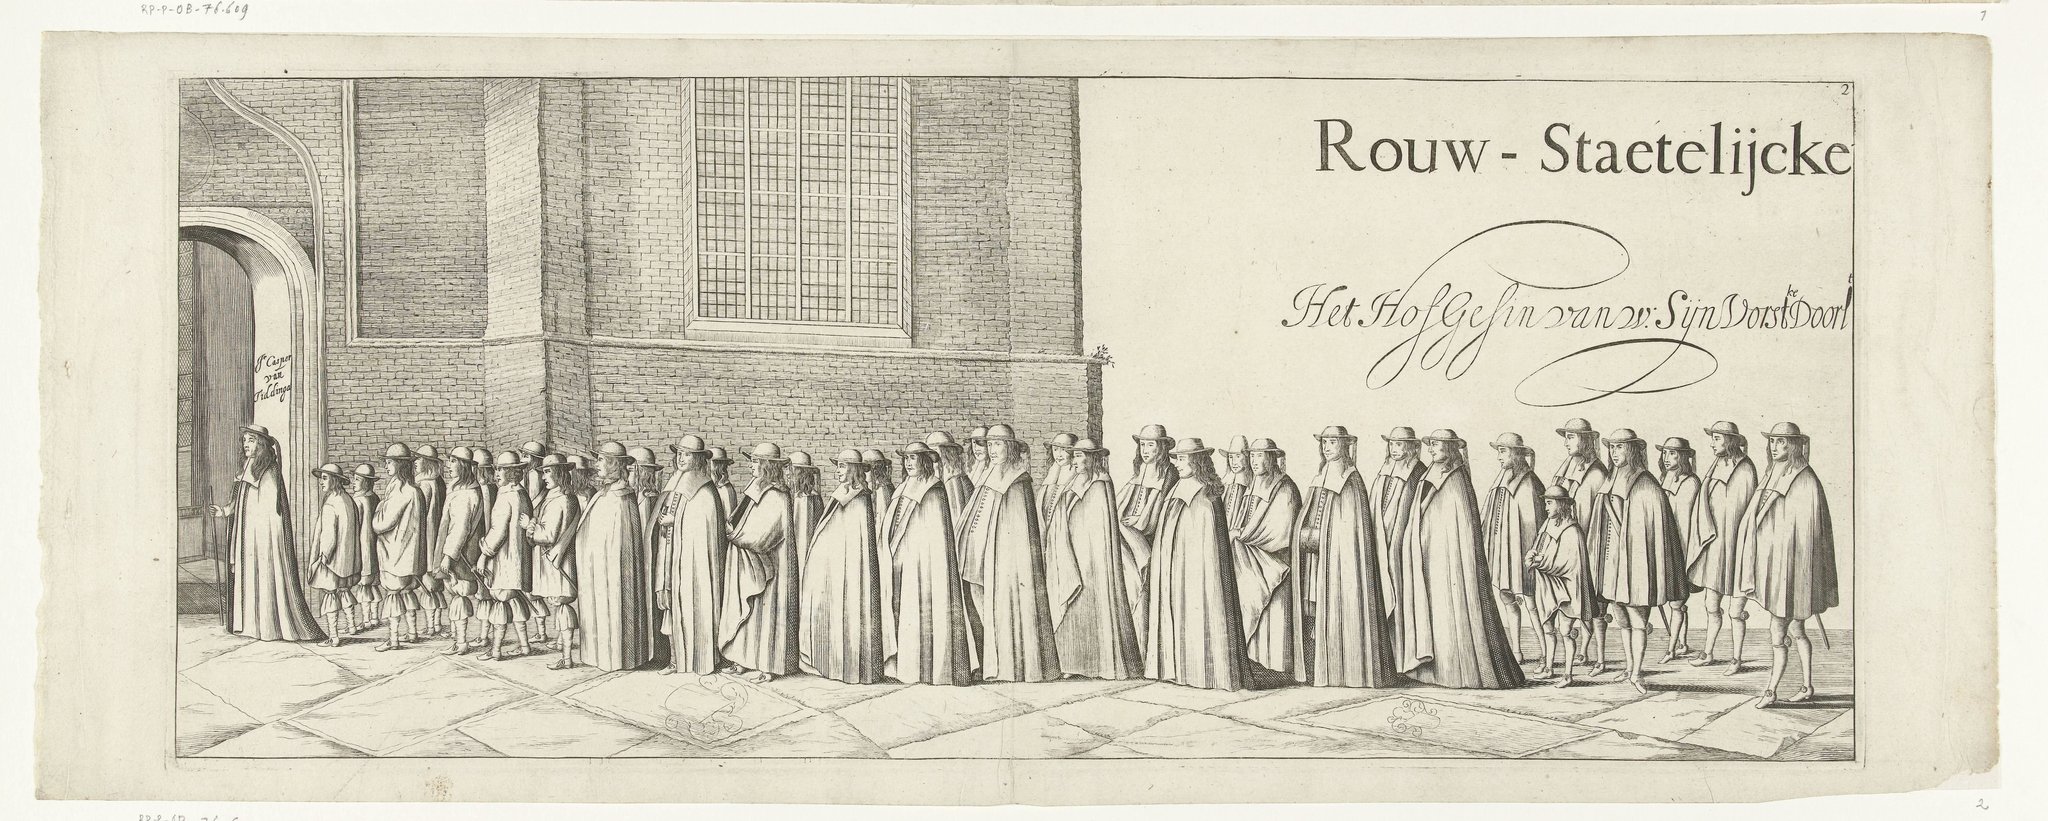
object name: print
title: Begrafenisoptocht van Willem Frederik, graaf van Nassau-Dietz (blad 2), 1665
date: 1666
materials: paper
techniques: engraving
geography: leeuwarden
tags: arnhem, cortege, funeral procession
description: Begrafenisoptocht van Willem Frederik, graaf van Nassau-Dietz, in Leeuwarden op 6 januari 1665. Begin van de begrafenisstoet bij de ingang van de Jacobijnerkerk. Plaat nr. 2 in een ensemble van 25 ongemonteerde genummerde platen en twee tekstbladen die samen een lange fries vormen.